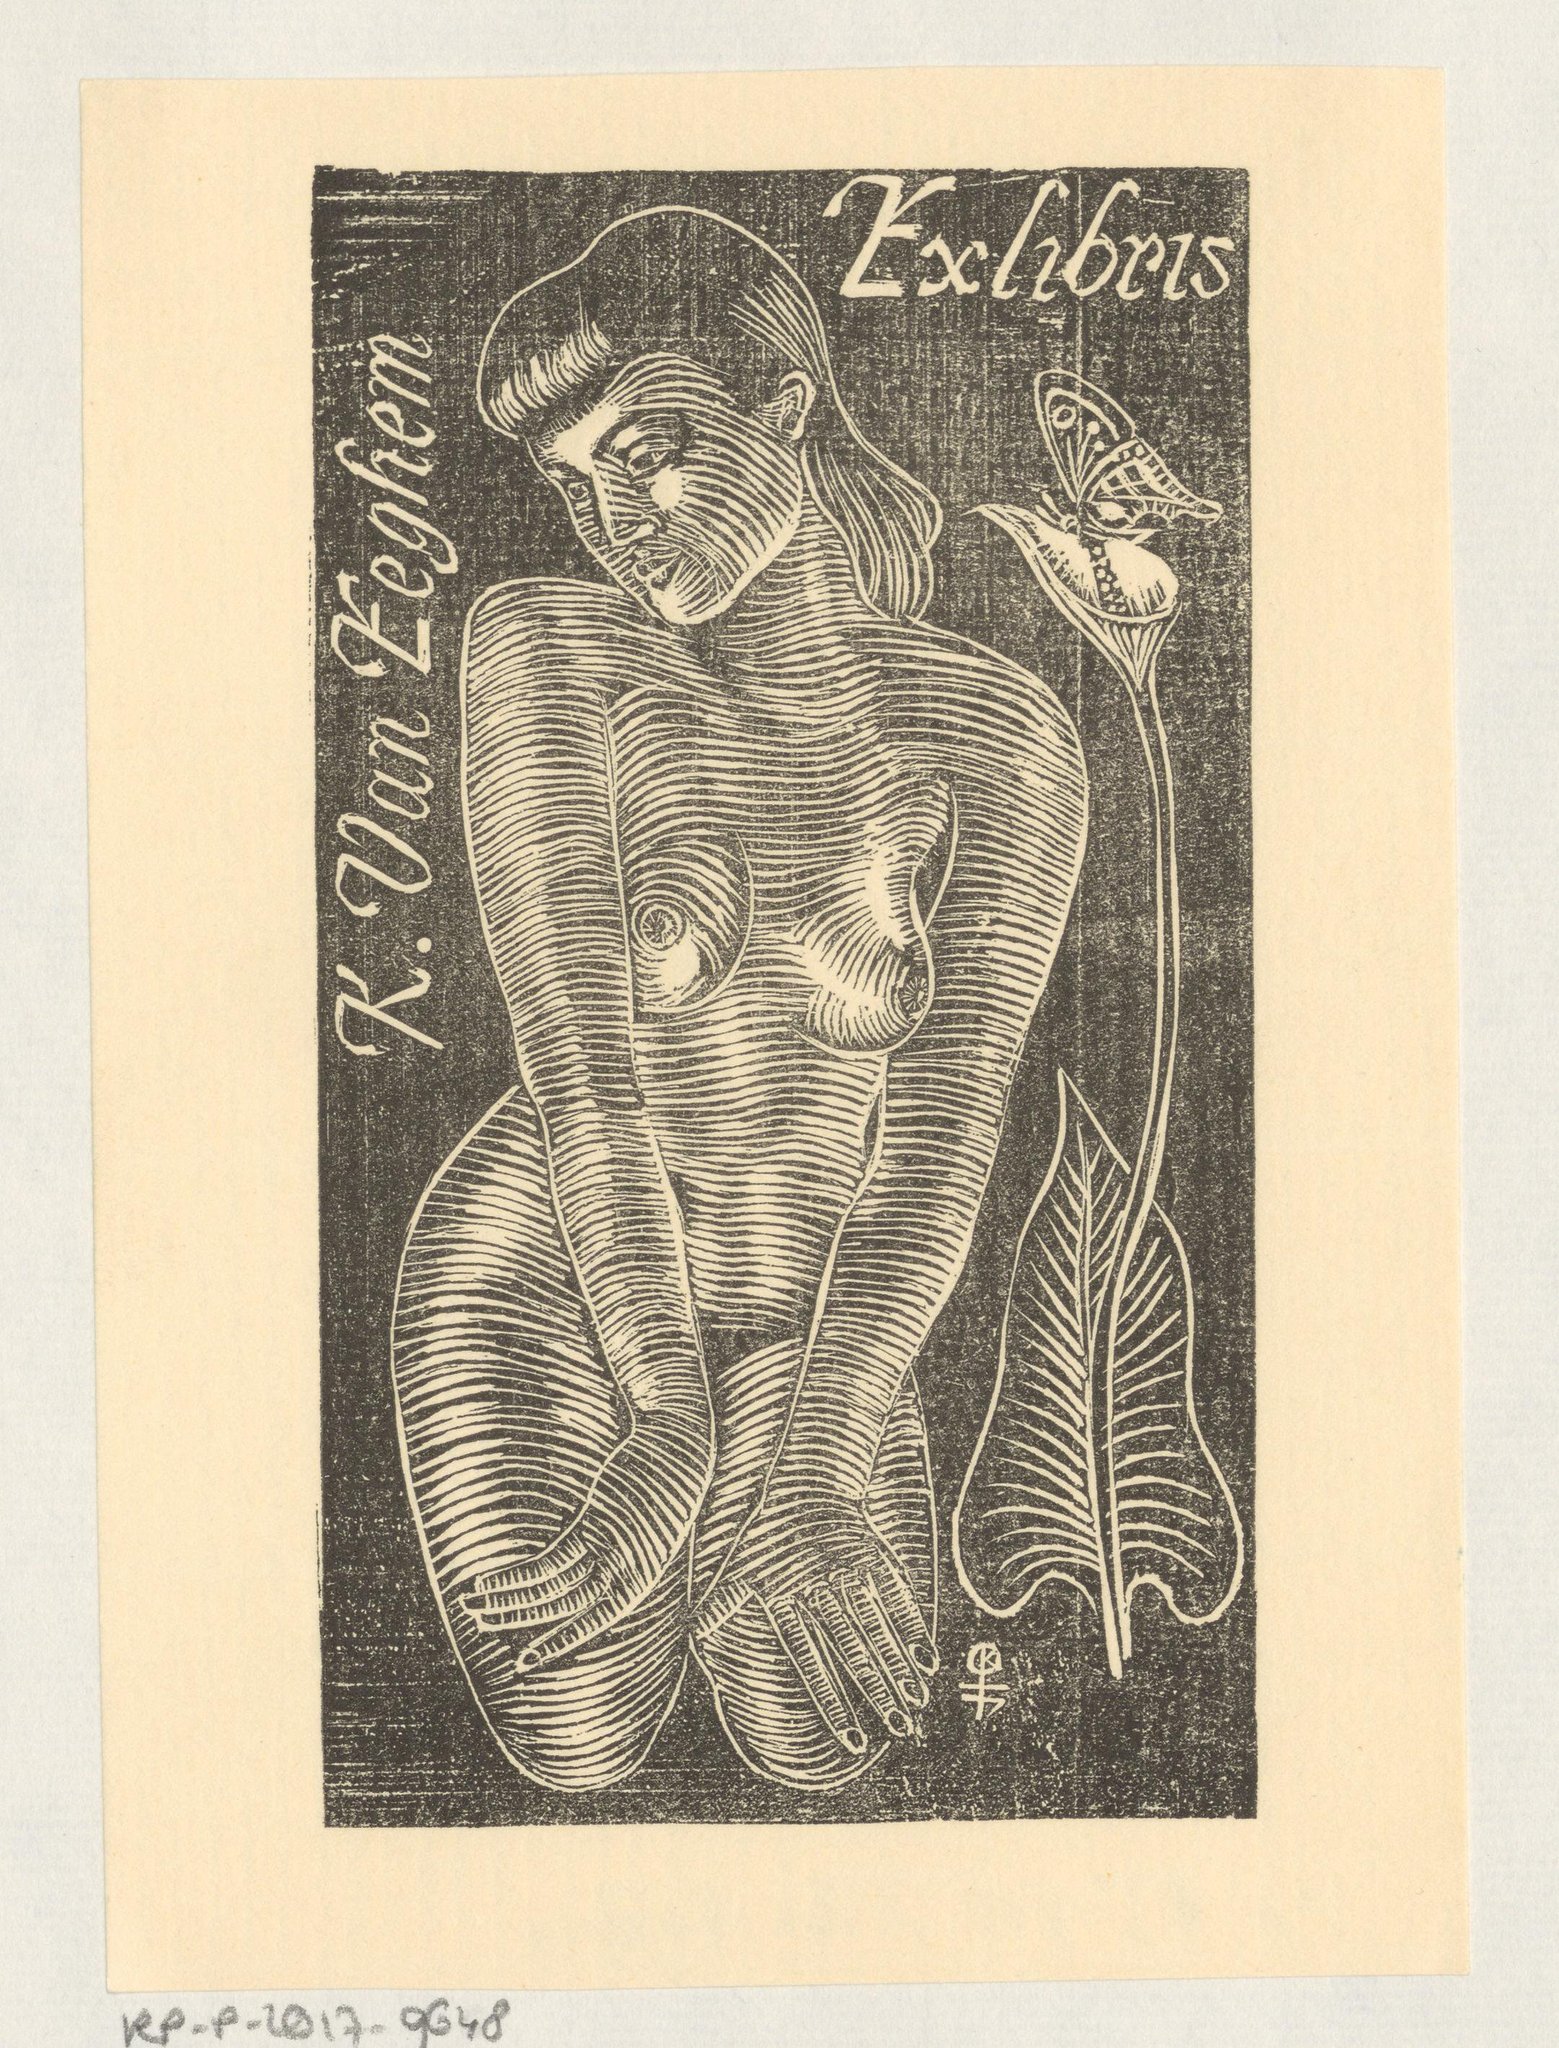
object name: bookplate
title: Ex libris van Karel van Eeghem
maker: karel van eeghem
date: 1958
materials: paper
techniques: woodcut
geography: belgium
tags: karel van eeghem, flowers, woman (showing herself) undressed, quasi-nude, insects: butterfly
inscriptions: inscription: ‘Xyl. 2 1958 K. van Eeghem’